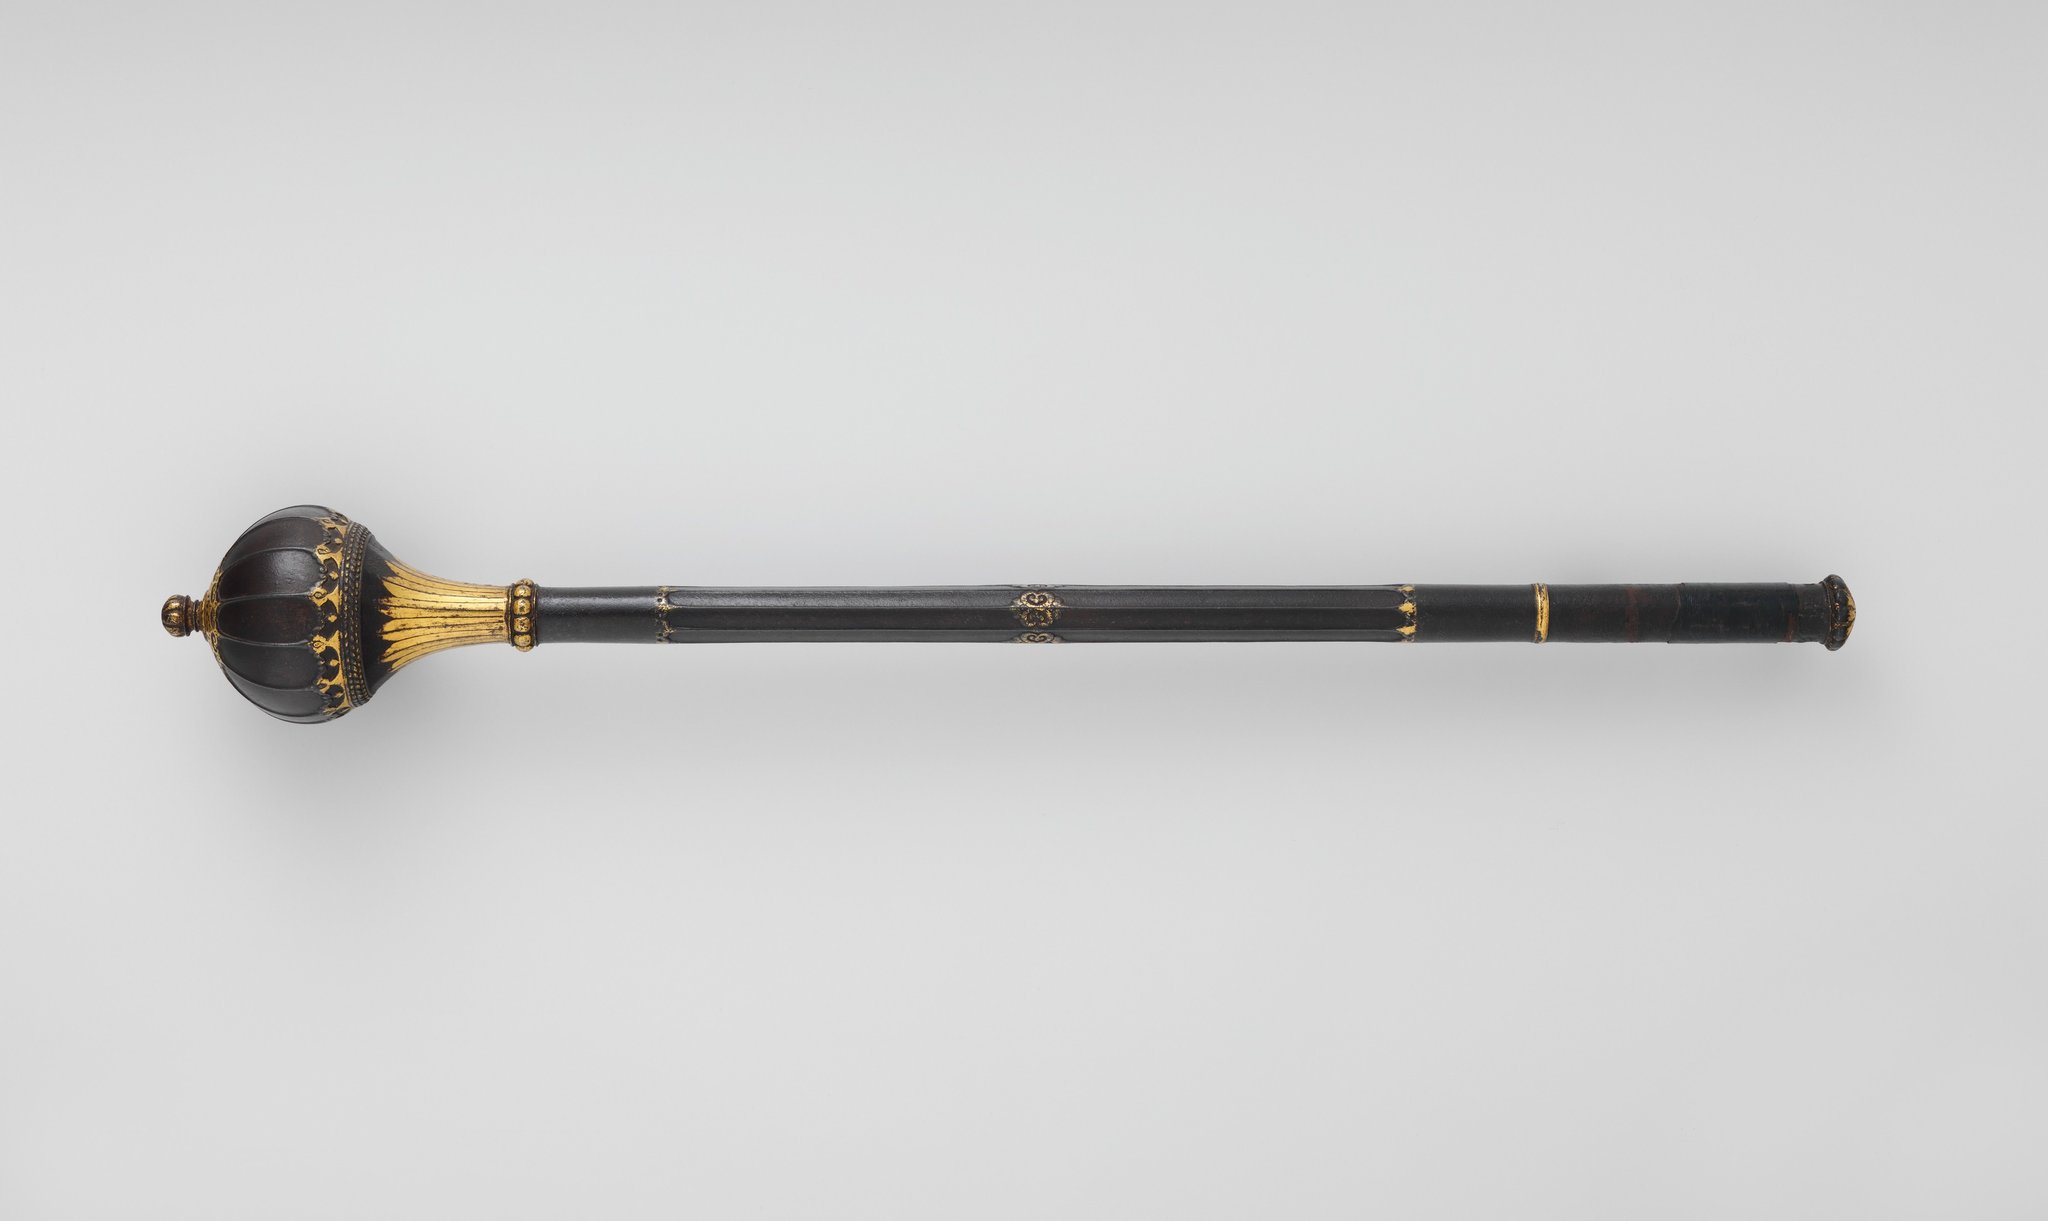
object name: mace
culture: deccan or north indian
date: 1701-1800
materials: gold, silk, steel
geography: india